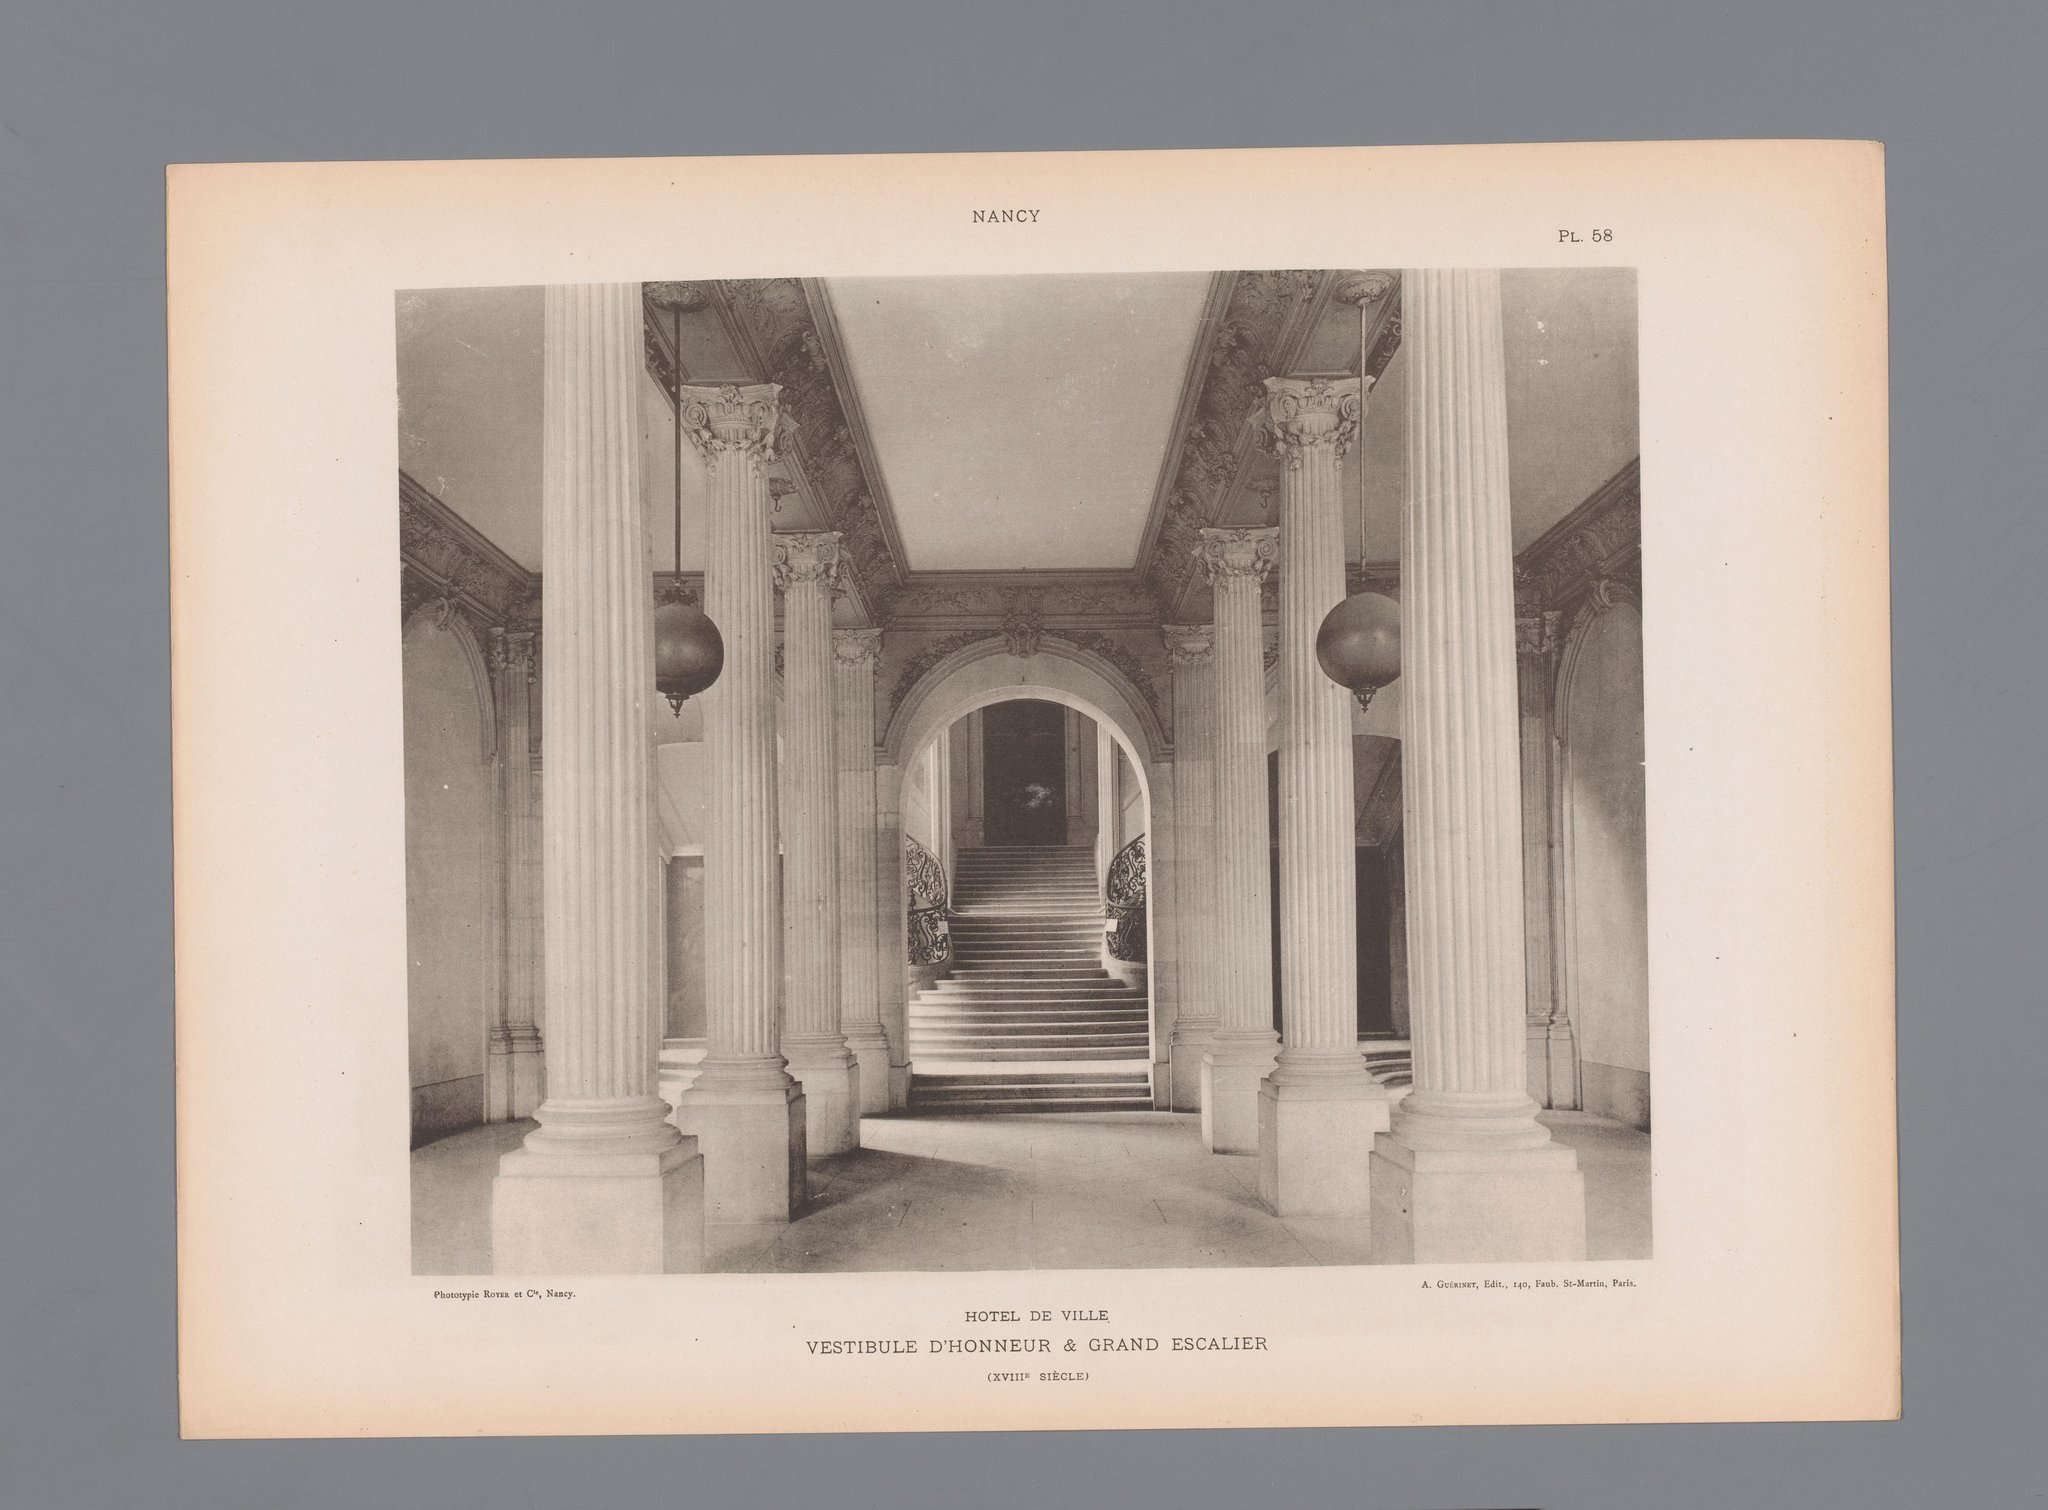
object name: photomechanical print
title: Hall met de grote trap in het stadhuis te Nancy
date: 1891-1896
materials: paper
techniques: photograph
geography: nancy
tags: townhall, vestibule, hall, staircase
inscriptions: inscription: ‘Hotel de ville/ Vestibule d'honneur & grand escalier (...)’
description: Deze prent maakt deel uit van een omslag met 103 prenten op 101 bladen en een titelblad.